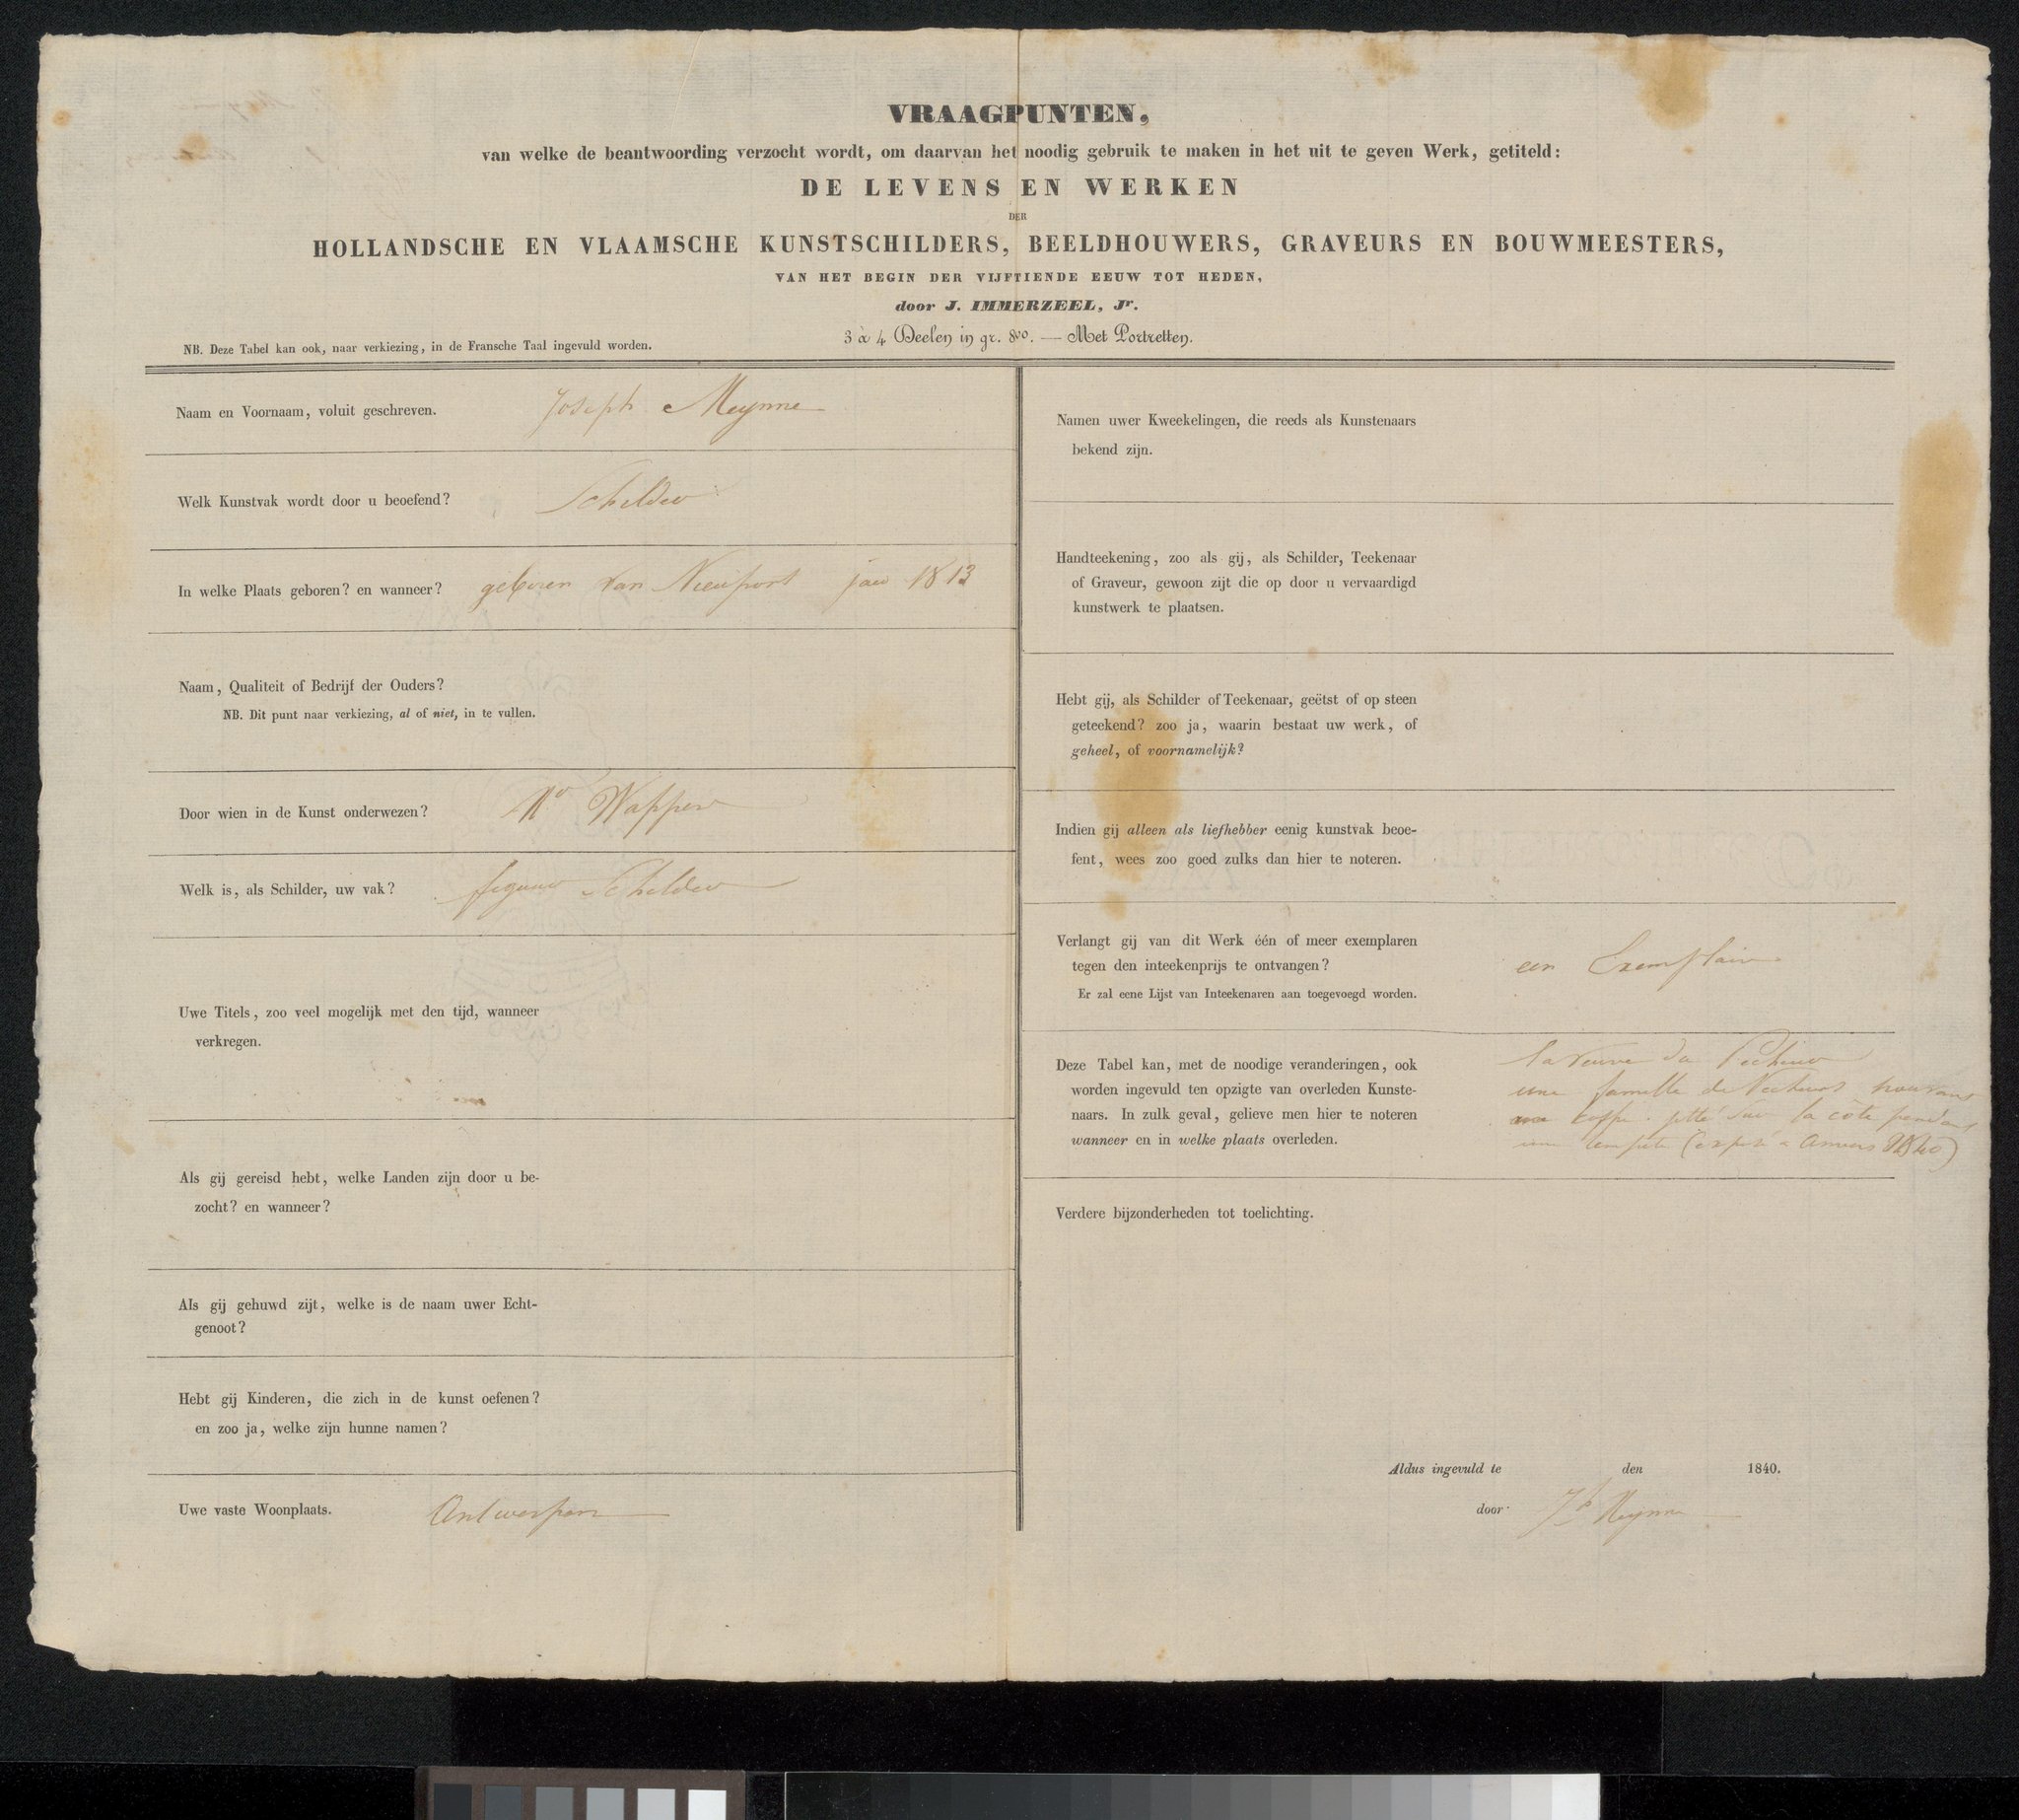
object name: questionnaire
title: Enquêteformulier ingevuld door Joseph Meijnne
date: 1840-1841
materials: ink, paper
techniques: pen, printing, writing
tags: painter, joseph meijnne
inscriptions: inscription: ‘Vraagpunten,/ van welke de beantwoording verzocht wordt, om daarvan het noodig gebruik te maken in het uit te geven Werk, getiteld: De levens en werken/ der Hollandsche en Vlaamsche kunstschilders, beeldhouwers,/ graveurs en bouwmeesters, van het begin der vijftiende eeuw tot heden/ door J. Immerzeel, Jr.’, watermark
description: Opgenomen in: Immerzeel, J. Jr., De levens en werken der Hollandsche en Vlaamsche kunstschilders, beeldhouwers, graveurs en bouwmeesters, van het begin der vijftiende eeuw tot heden, Amsterdam: J.C. van Kesteren, 1842-1843.